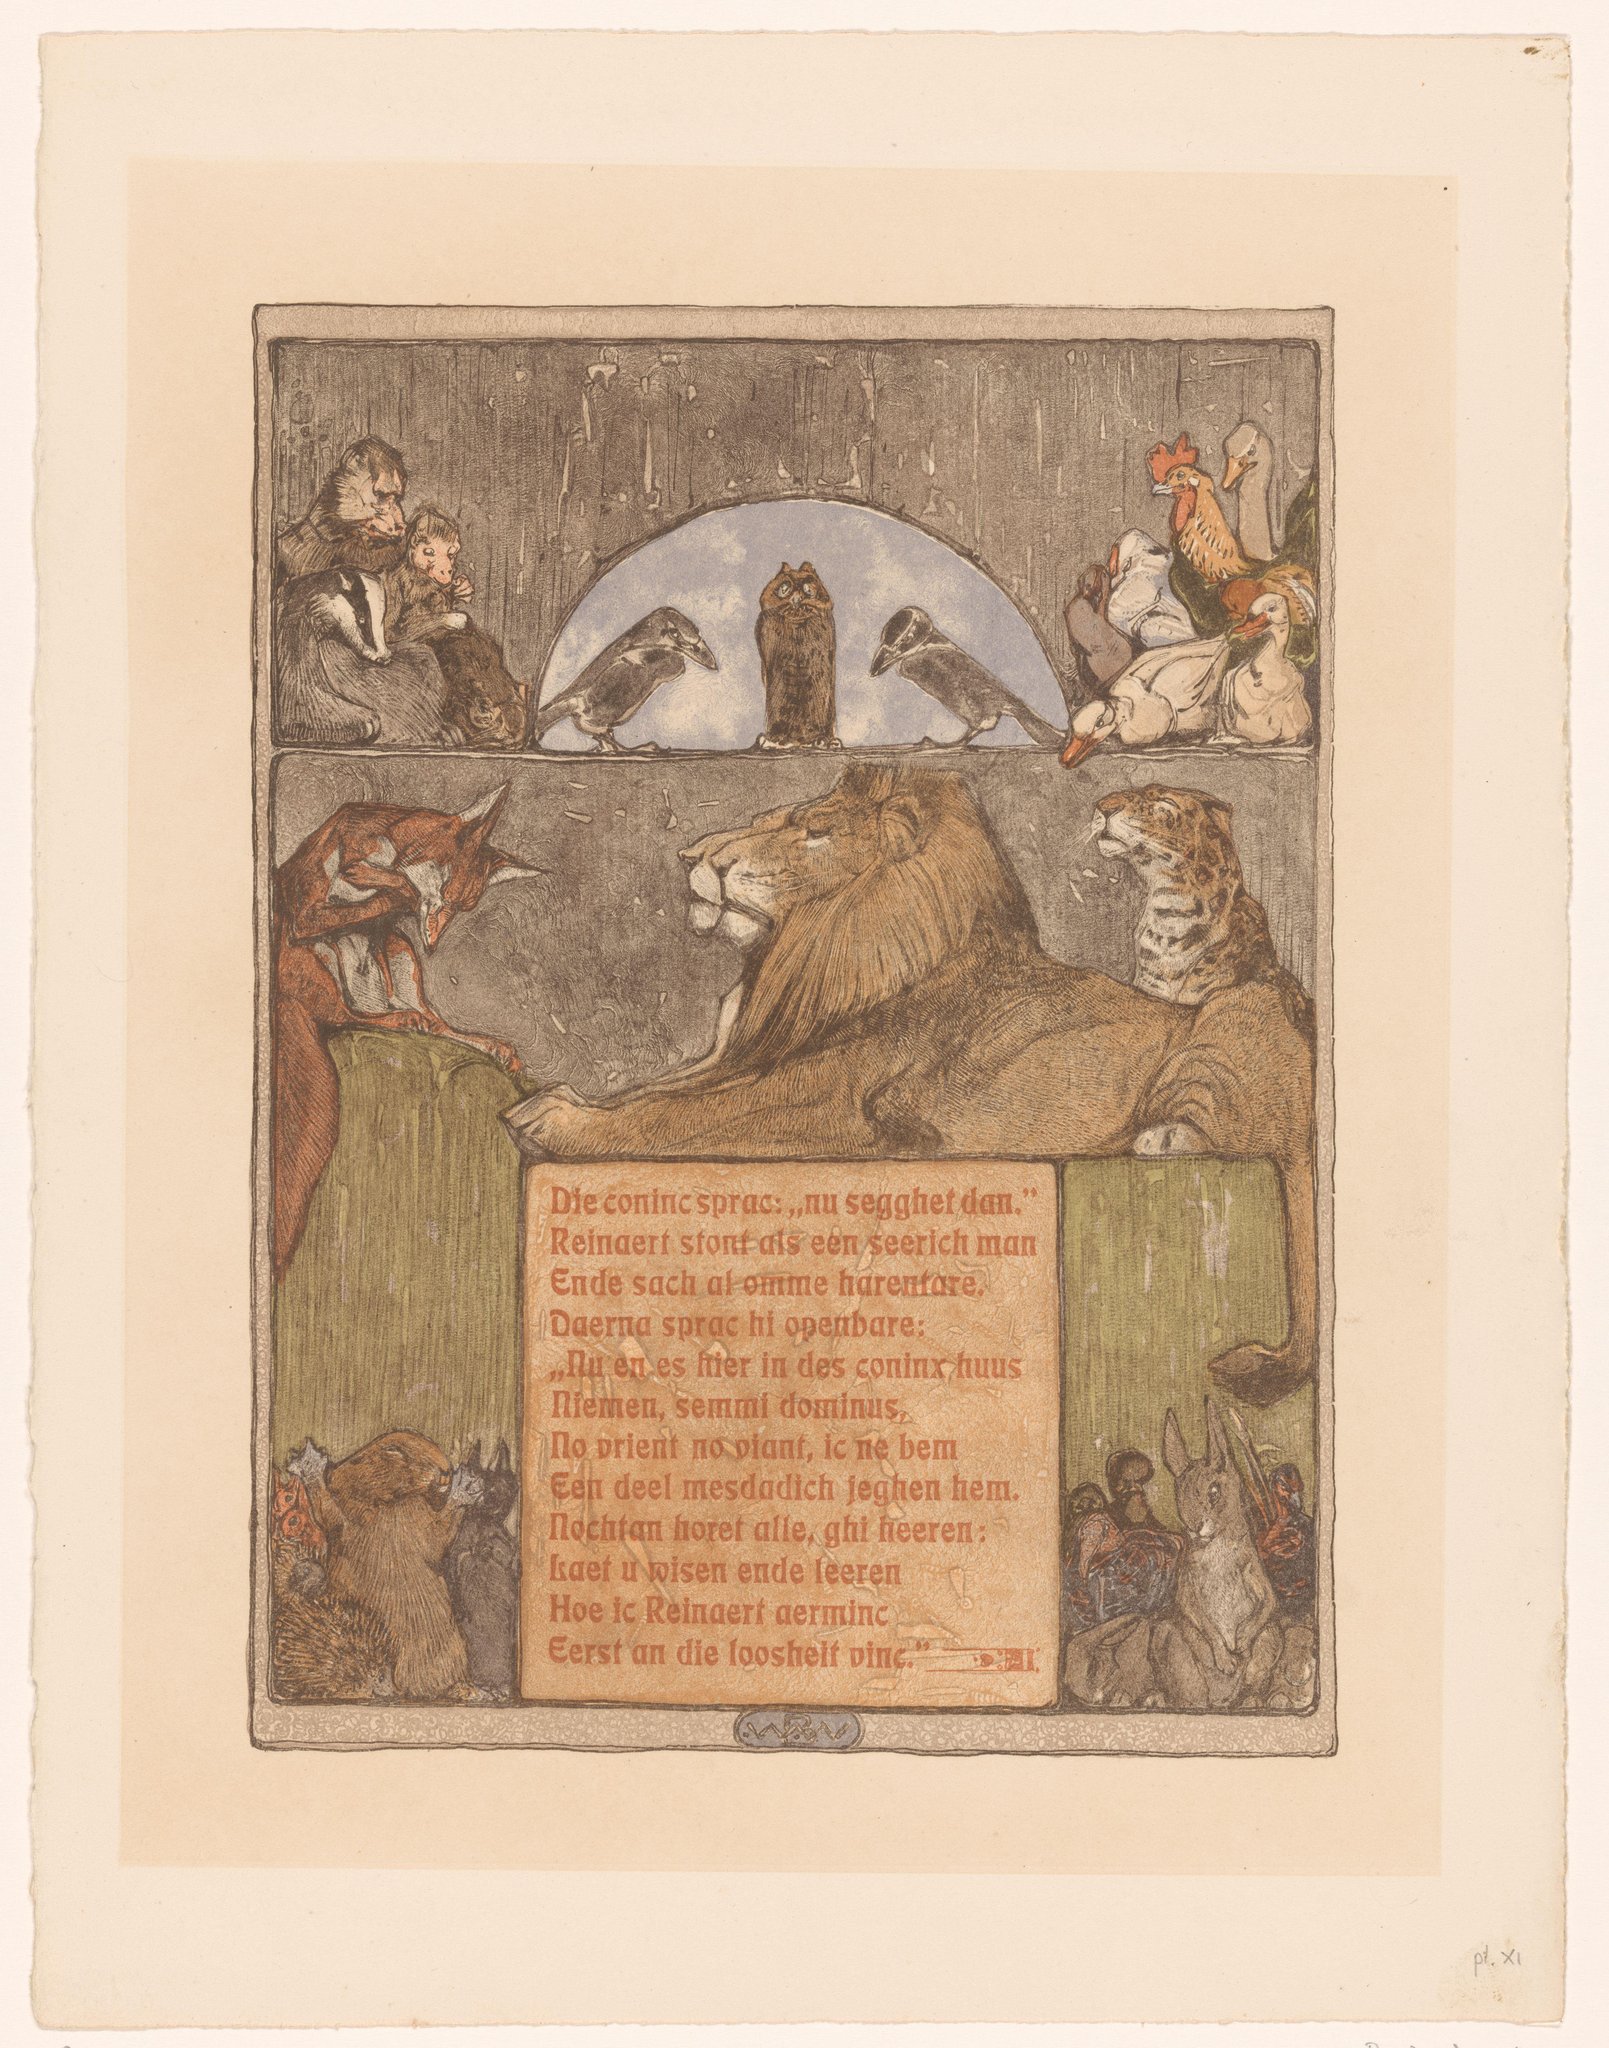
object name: print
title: Vos (Reinaert) voor leeuw (Nobel) en andere dieren in tribunaal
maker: bernard willem wierink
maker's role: draughtsman, print maker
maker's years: 1856-1939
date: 1910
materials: paper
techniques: lithograph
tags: fable of reynard the fox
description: Prent gebruikt in: Streuvels, Stijn (Frank Lateur). Reinaert de Vos naar verschillende uitgaven van het middeleeuwsche epos. Amsterdam: L.J. Veen, 1910.